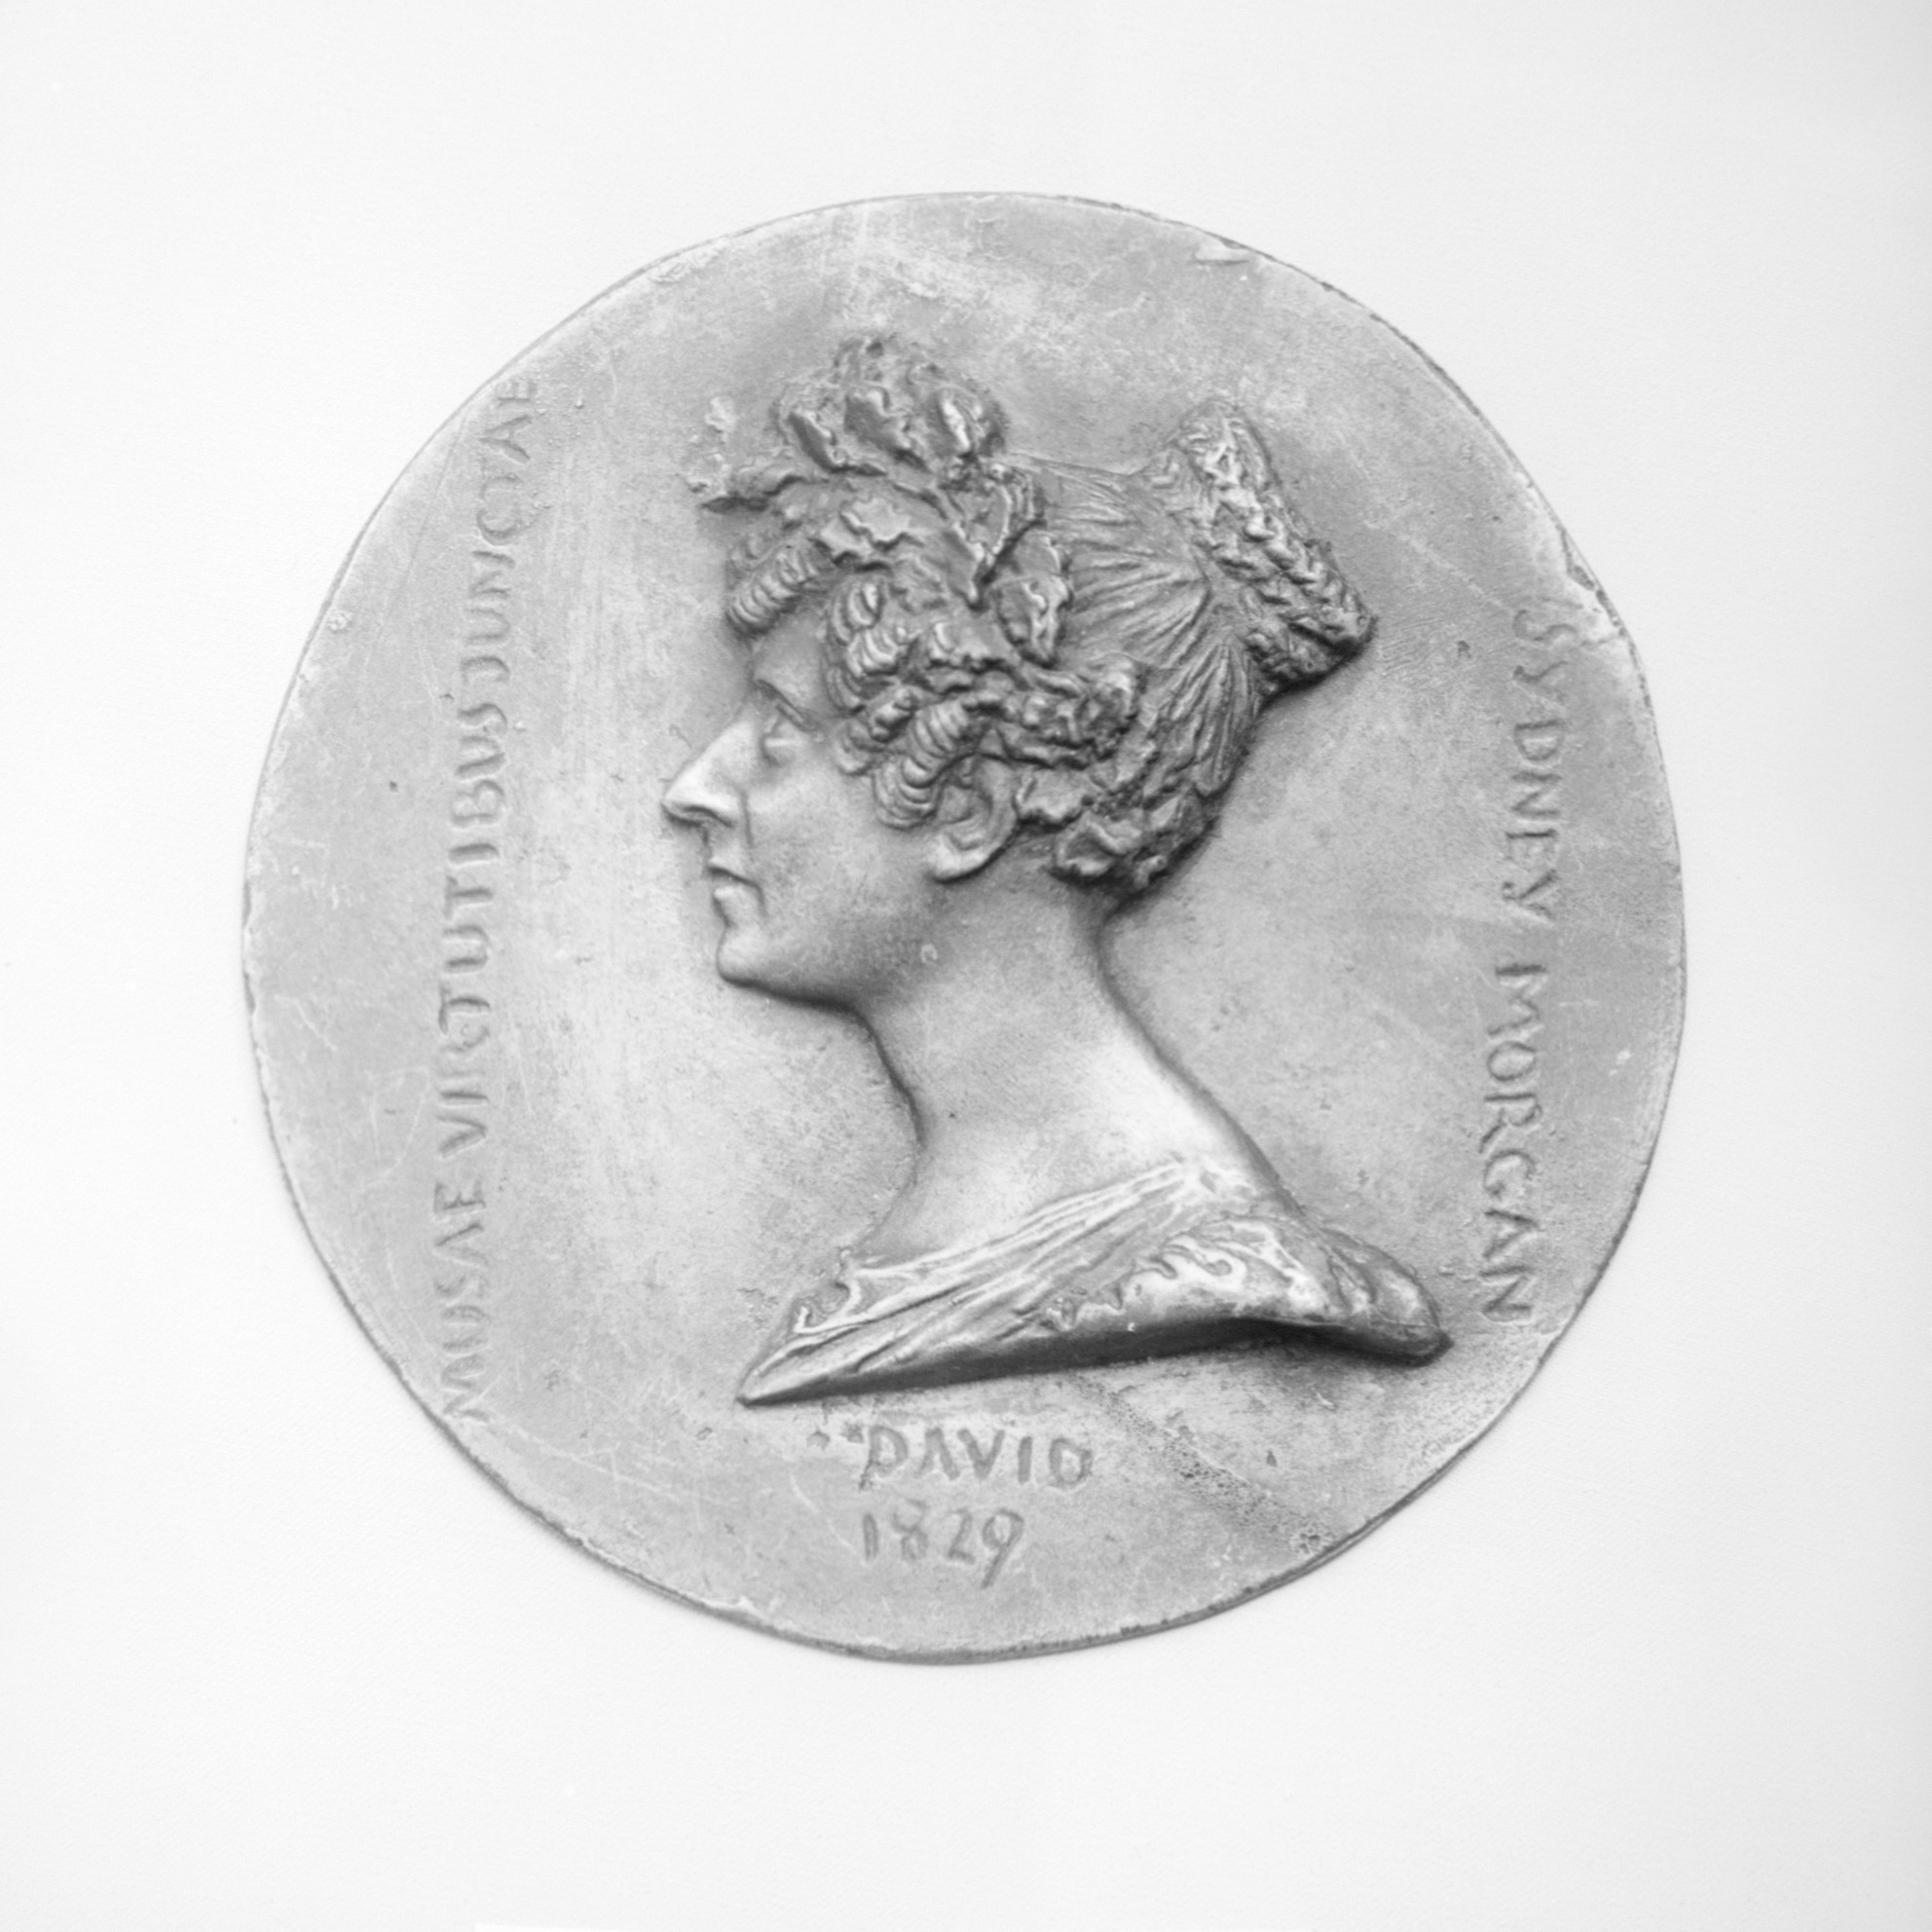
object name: medallion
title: Sydney Lady Morgan (née Owenson), Irish novelist (1777–1859)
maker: pierre jean david d'angers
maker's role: artist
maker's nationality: french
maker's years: 1788-1856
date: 1829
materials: bronze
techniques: casting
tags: profiles,women